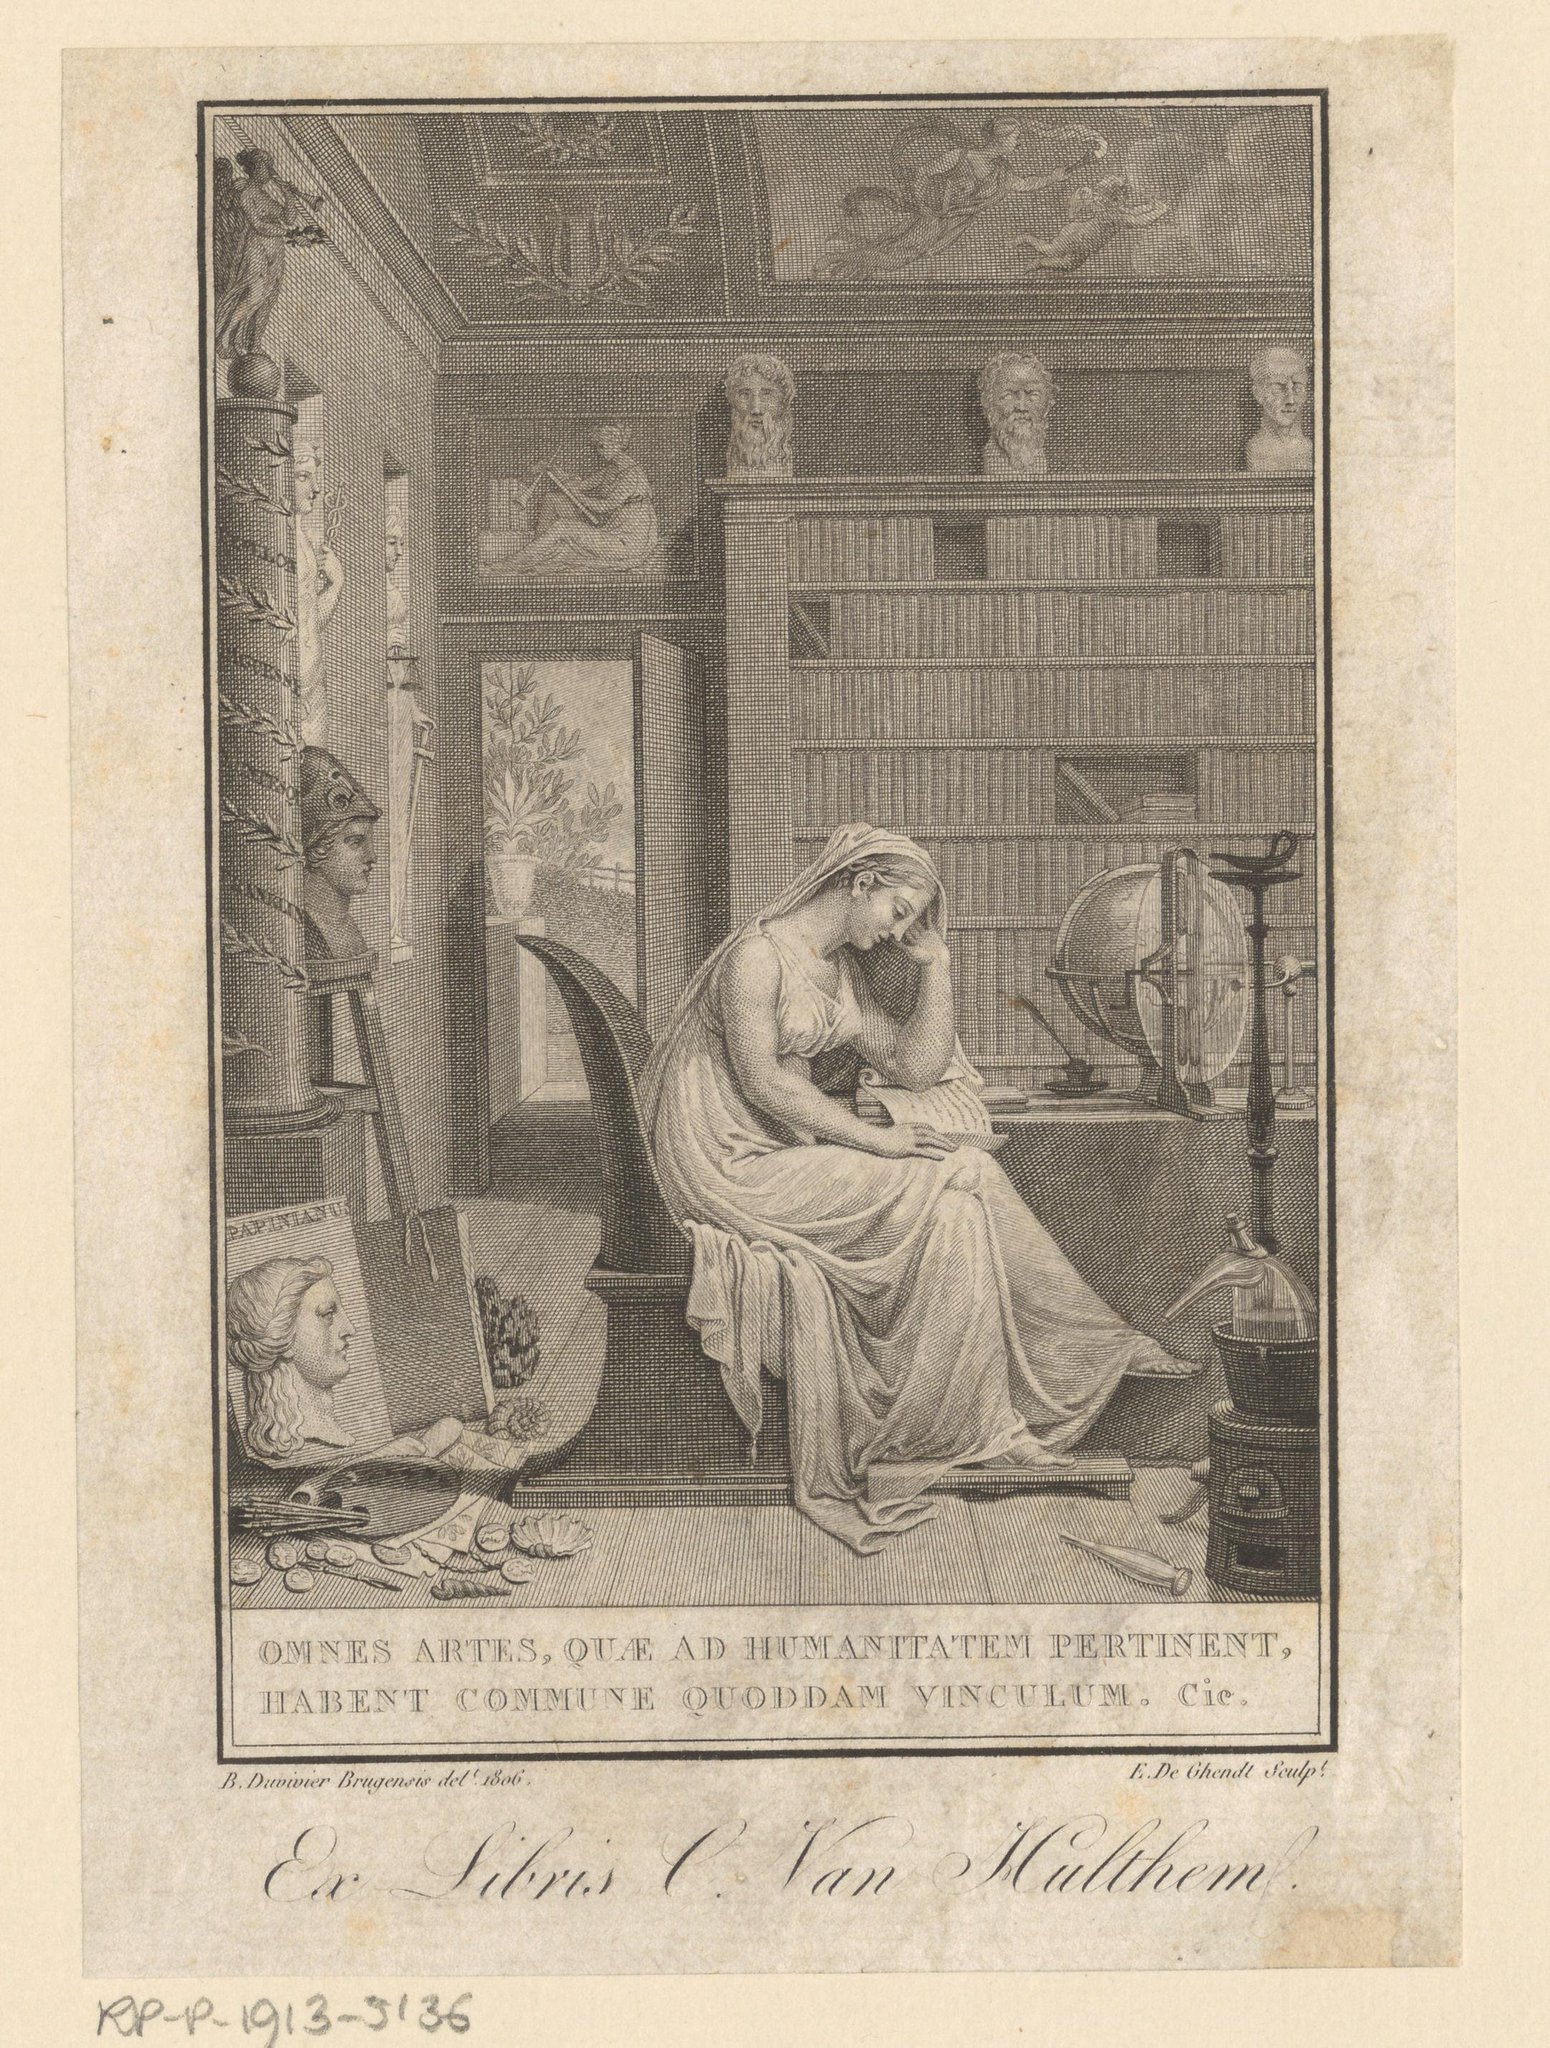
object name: bookplate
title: Omnes artes, quae ad humanitatem pertinent, habent commune quoddam vinculum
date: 1806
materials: paper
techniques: engraving, etching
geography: belgium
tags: ghent, politician, reading, sitting figure - aa - female human figure, study; 'studiolo'; library, globe, philosophy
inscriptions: collector's mark: Lugt 2760, collector's mark: Lugt 2233